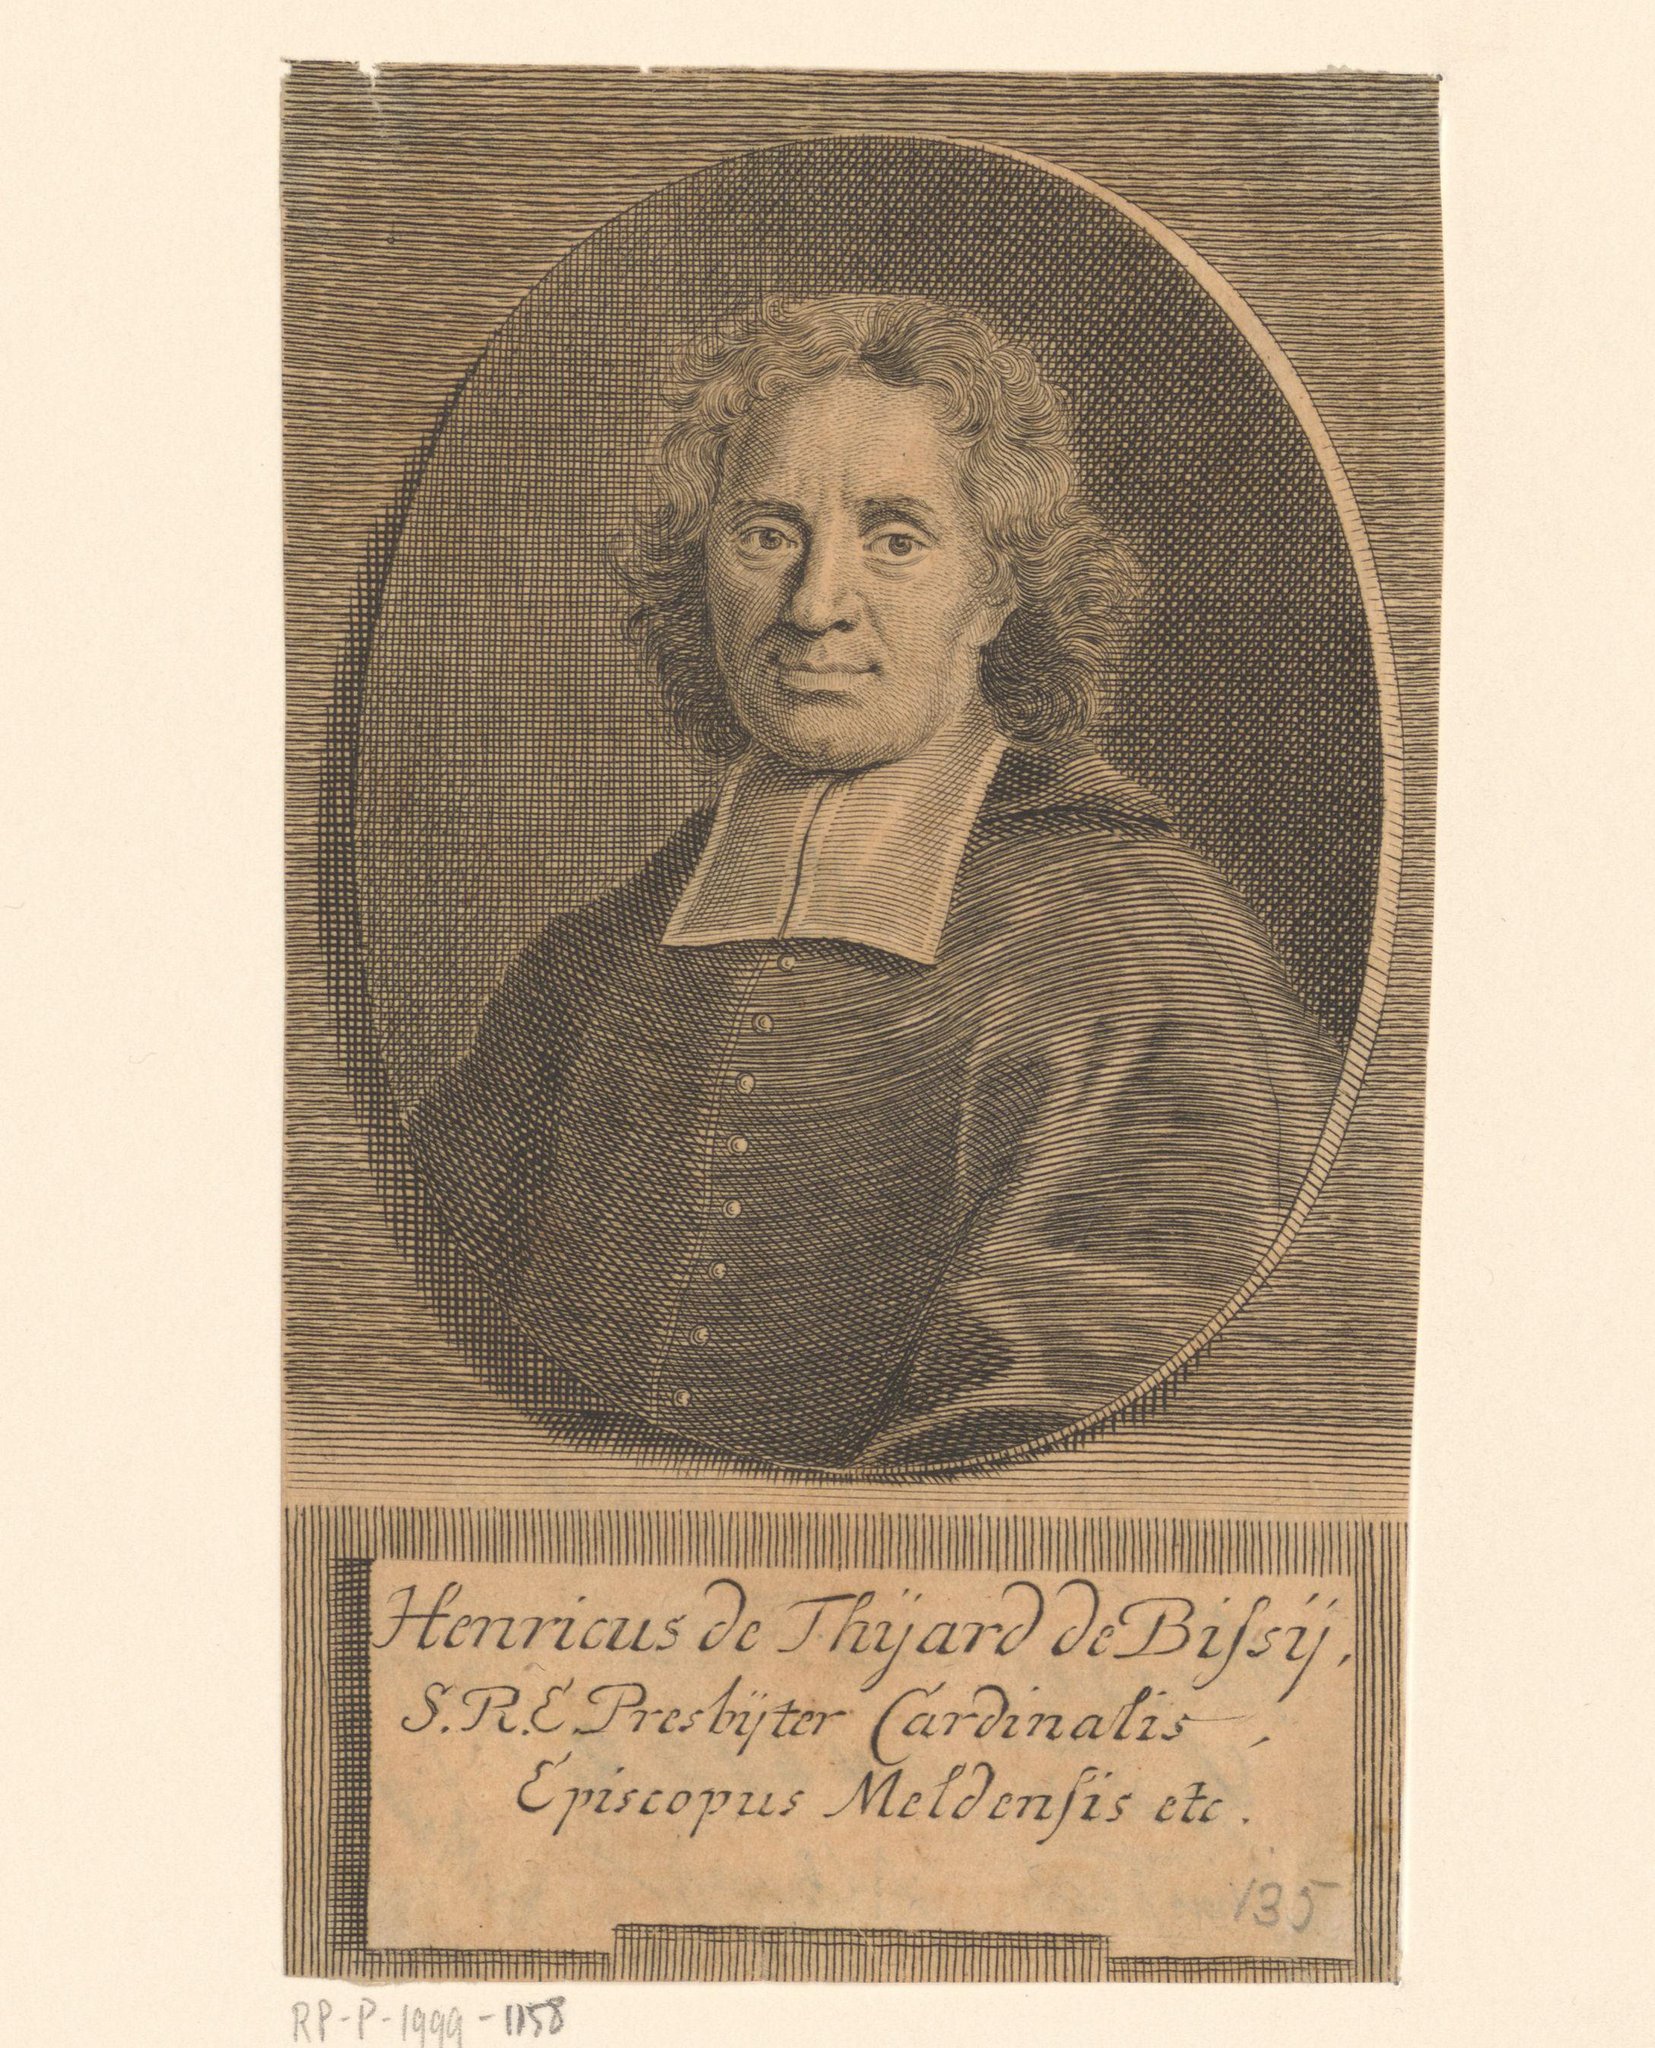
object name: print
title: Portret van Henri de Thiard de Bissy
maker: martin bernigeroth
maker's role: print maker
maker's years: 1670-1733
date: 1719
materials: paper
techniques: engraving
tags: paris, archbishop, bishop, etc. (roman catholic), historical persons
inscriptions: collector's mark: Lugt 2228, collector's mark: Lugt 2760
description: Prent uit: Die Europäische Fama, welche den gegenwärtigen Zustand der vornehmsten Höfe entdecket. S.l.s.n., 1719, dl. 227.